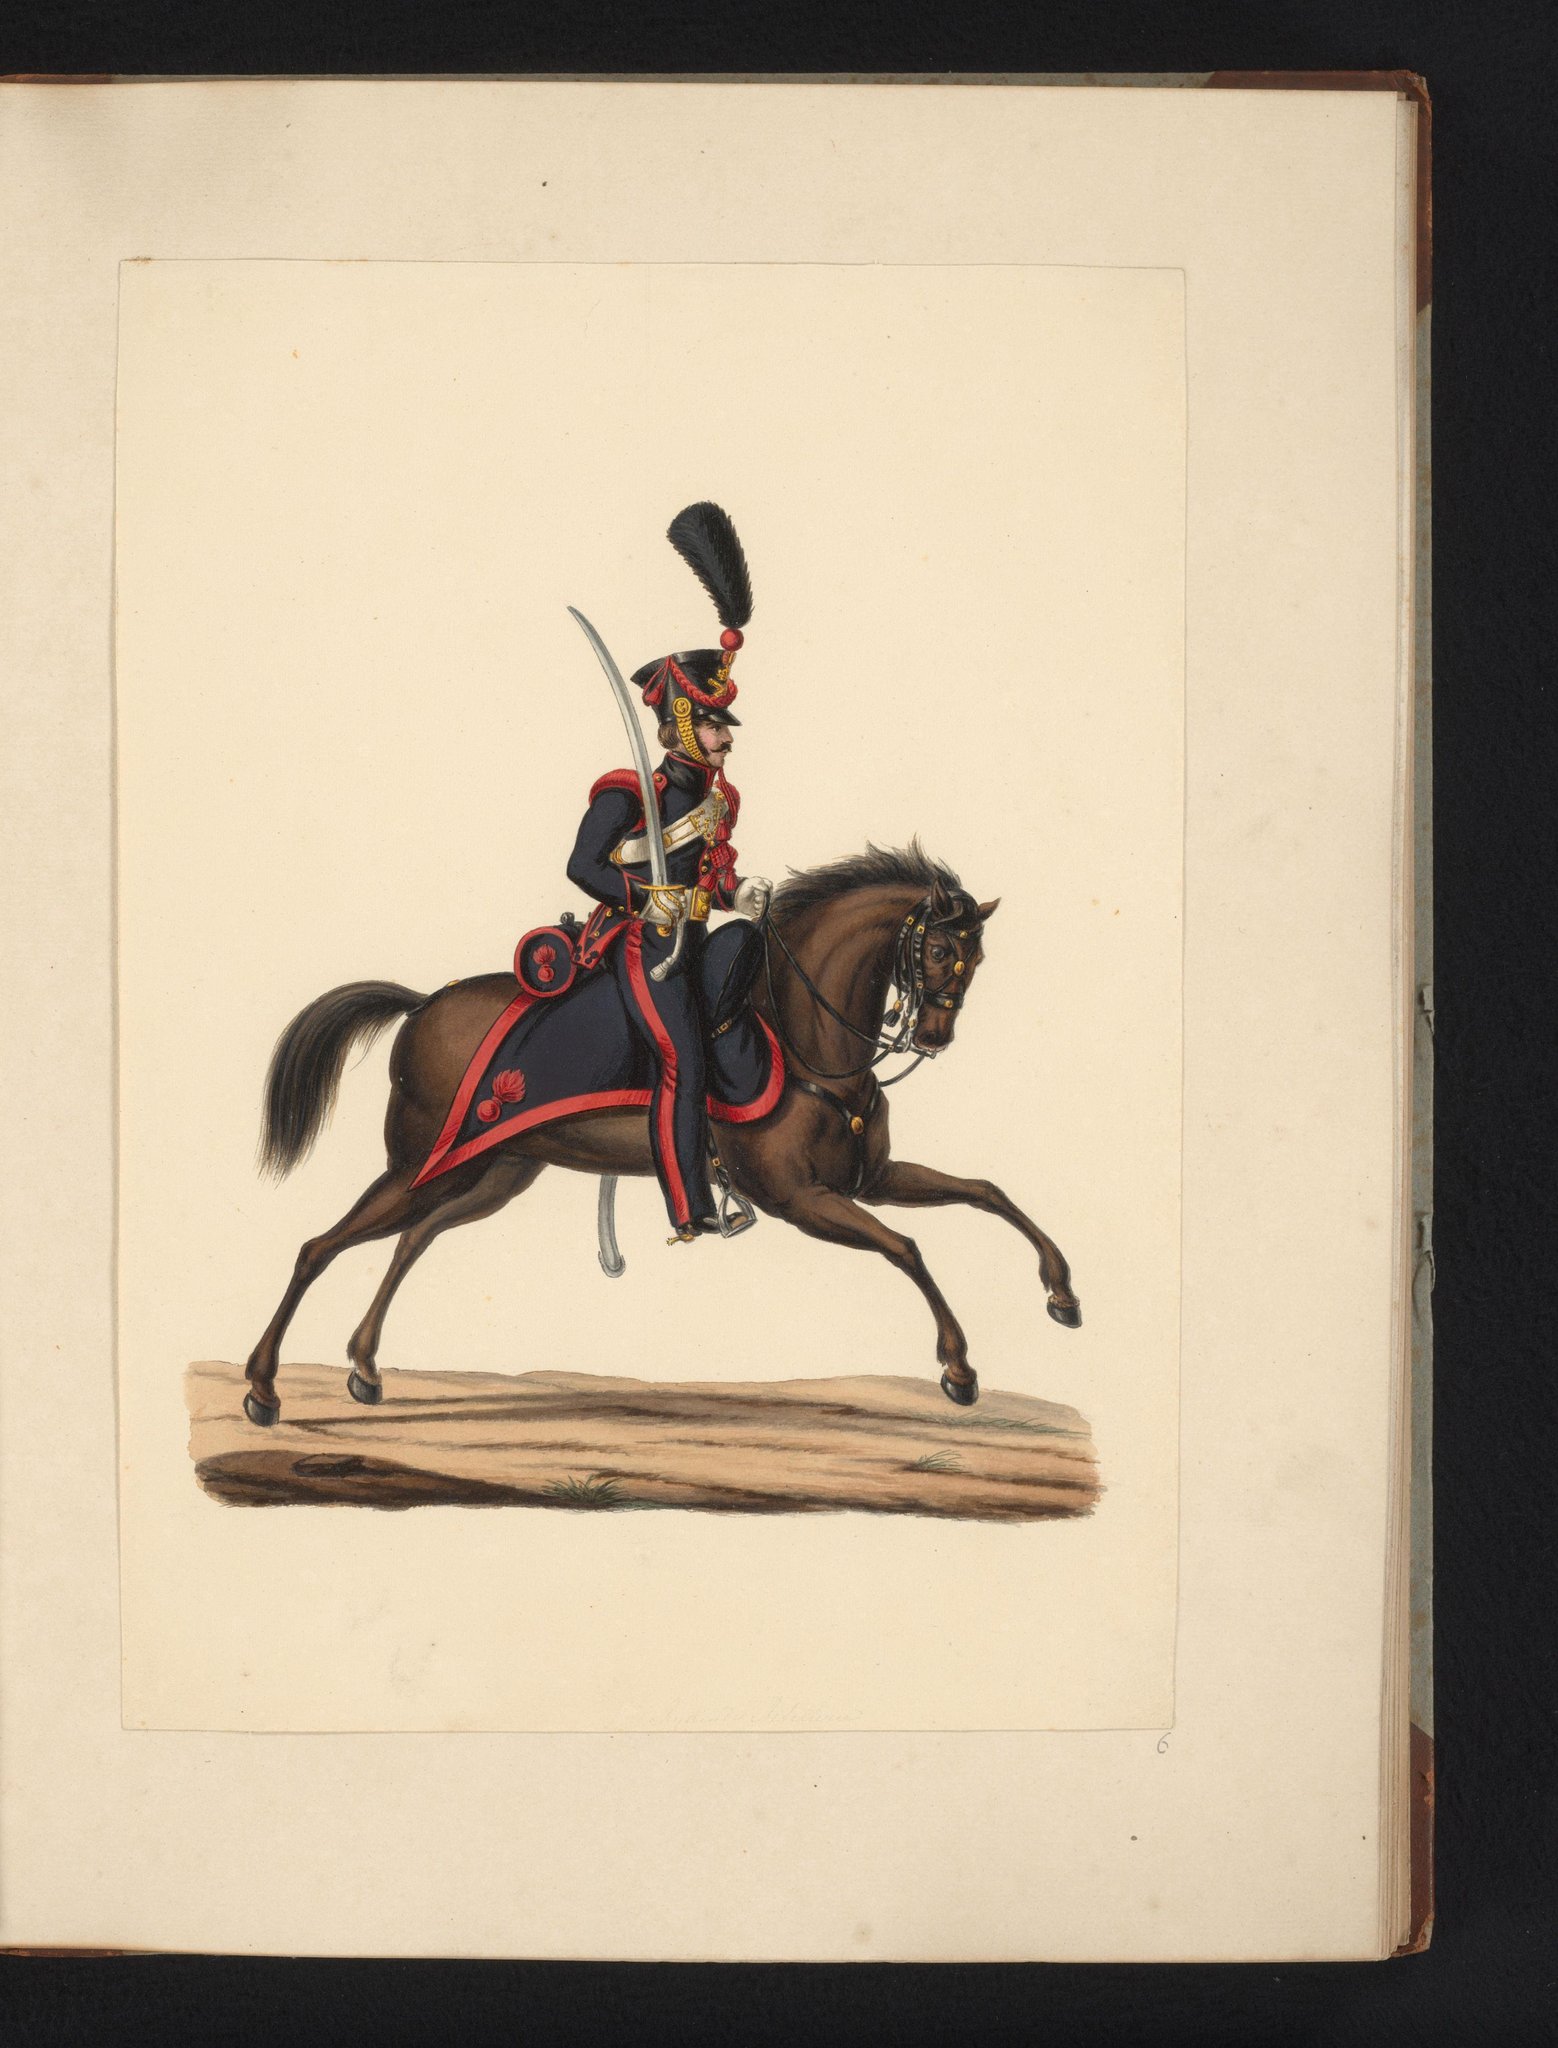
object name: costume print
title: Artillerist van de rijdende artillerie, 1830-1831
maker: Anonymous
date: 1831-1832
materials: paper, pencil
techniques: brush, lacquer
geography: netherlands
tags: professional clothes, (military) uniforms, netherlands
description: Een artillerist van de rijdende artillerie, te paard. Onderdeel van het album met 39 ingeplakte tekeningen van militairen van de Koninklijke Nederlandsche Armee uit 1830-1831.